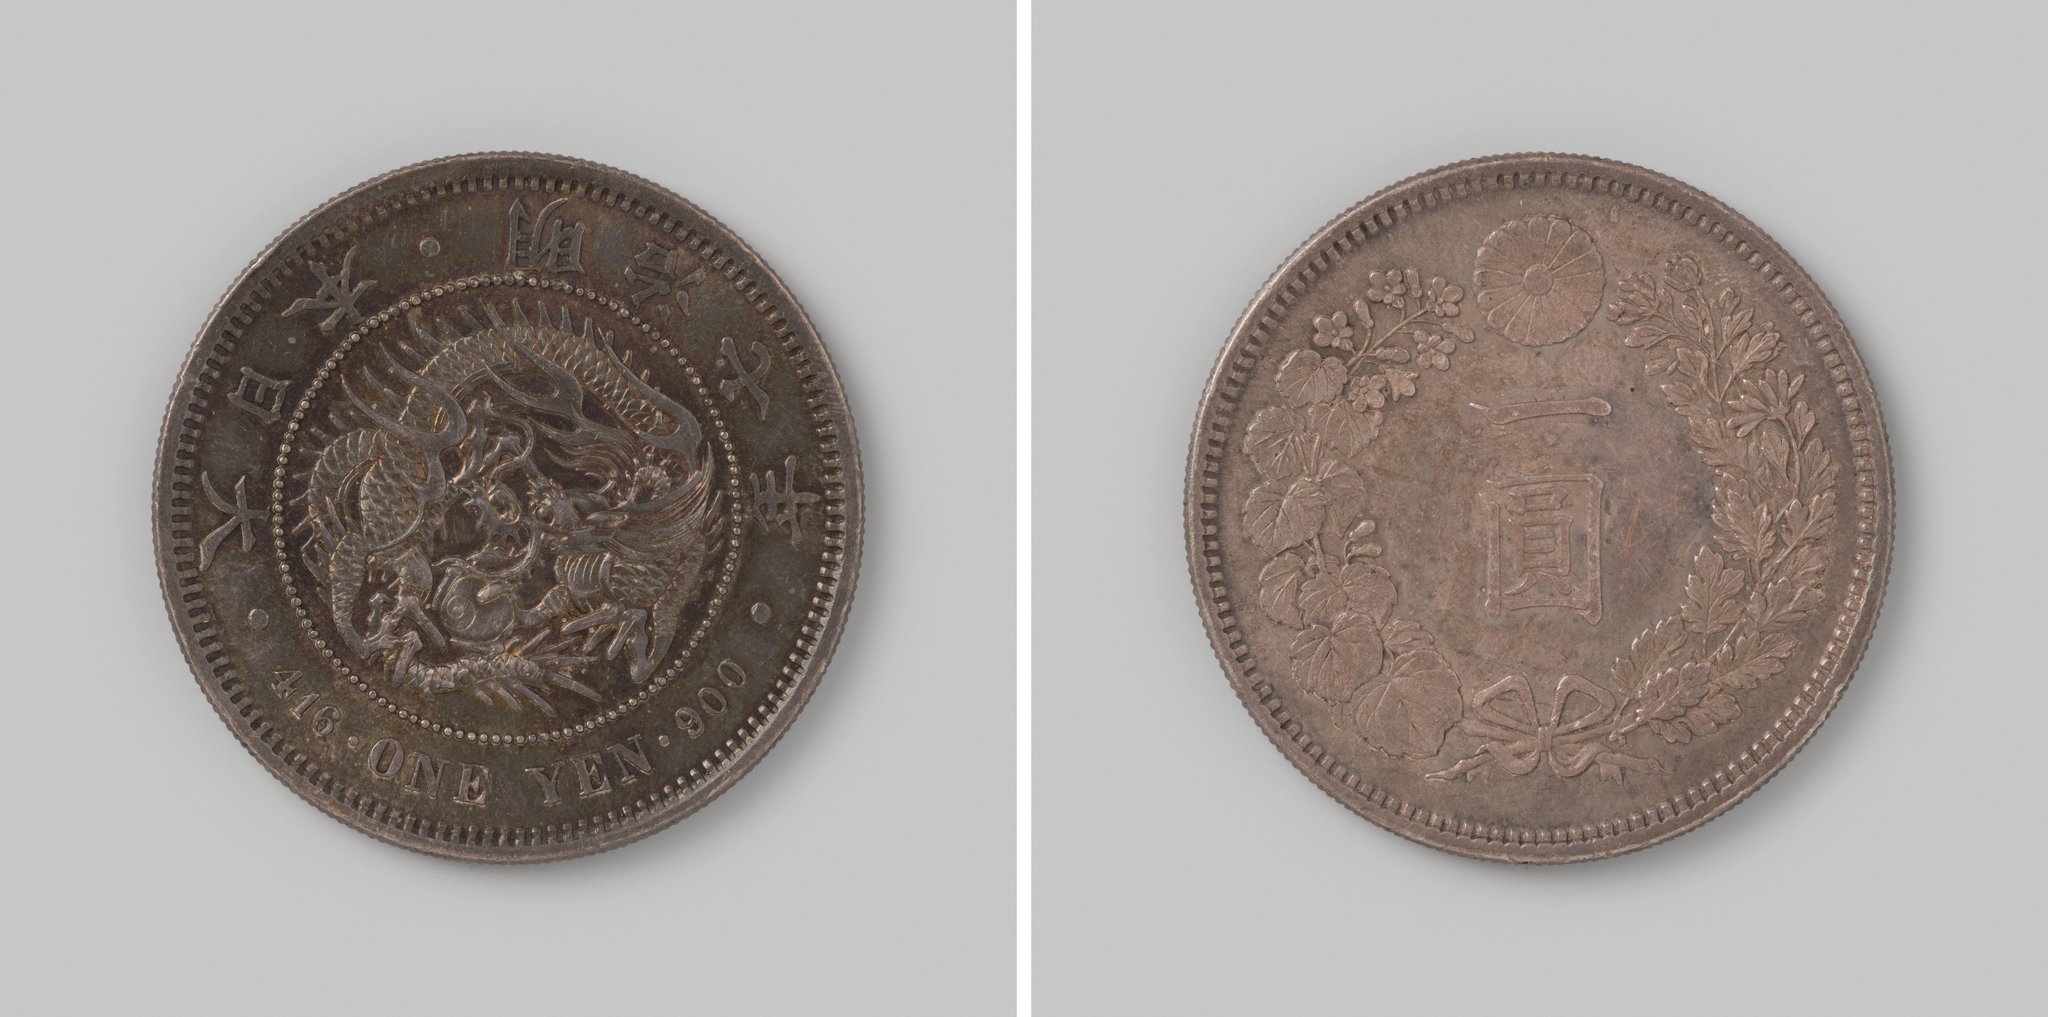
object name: coin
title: Keizerrijk Japan, Meiji tijdperk, yen, regeringsjaar 7 [=1874]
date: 1874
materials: silver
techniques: striking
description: Zilveren munt. Voorzijde: binnen cirkel gestileerde draak met in omschrift onderaan waarde-aanduiding: een, aangegeven door een liggende streep. Keerzijde: binnen twee samengebonden takken, waarboven een symbool, op twee regels onder elkaar waarde-aanduiding. Kartelrand.